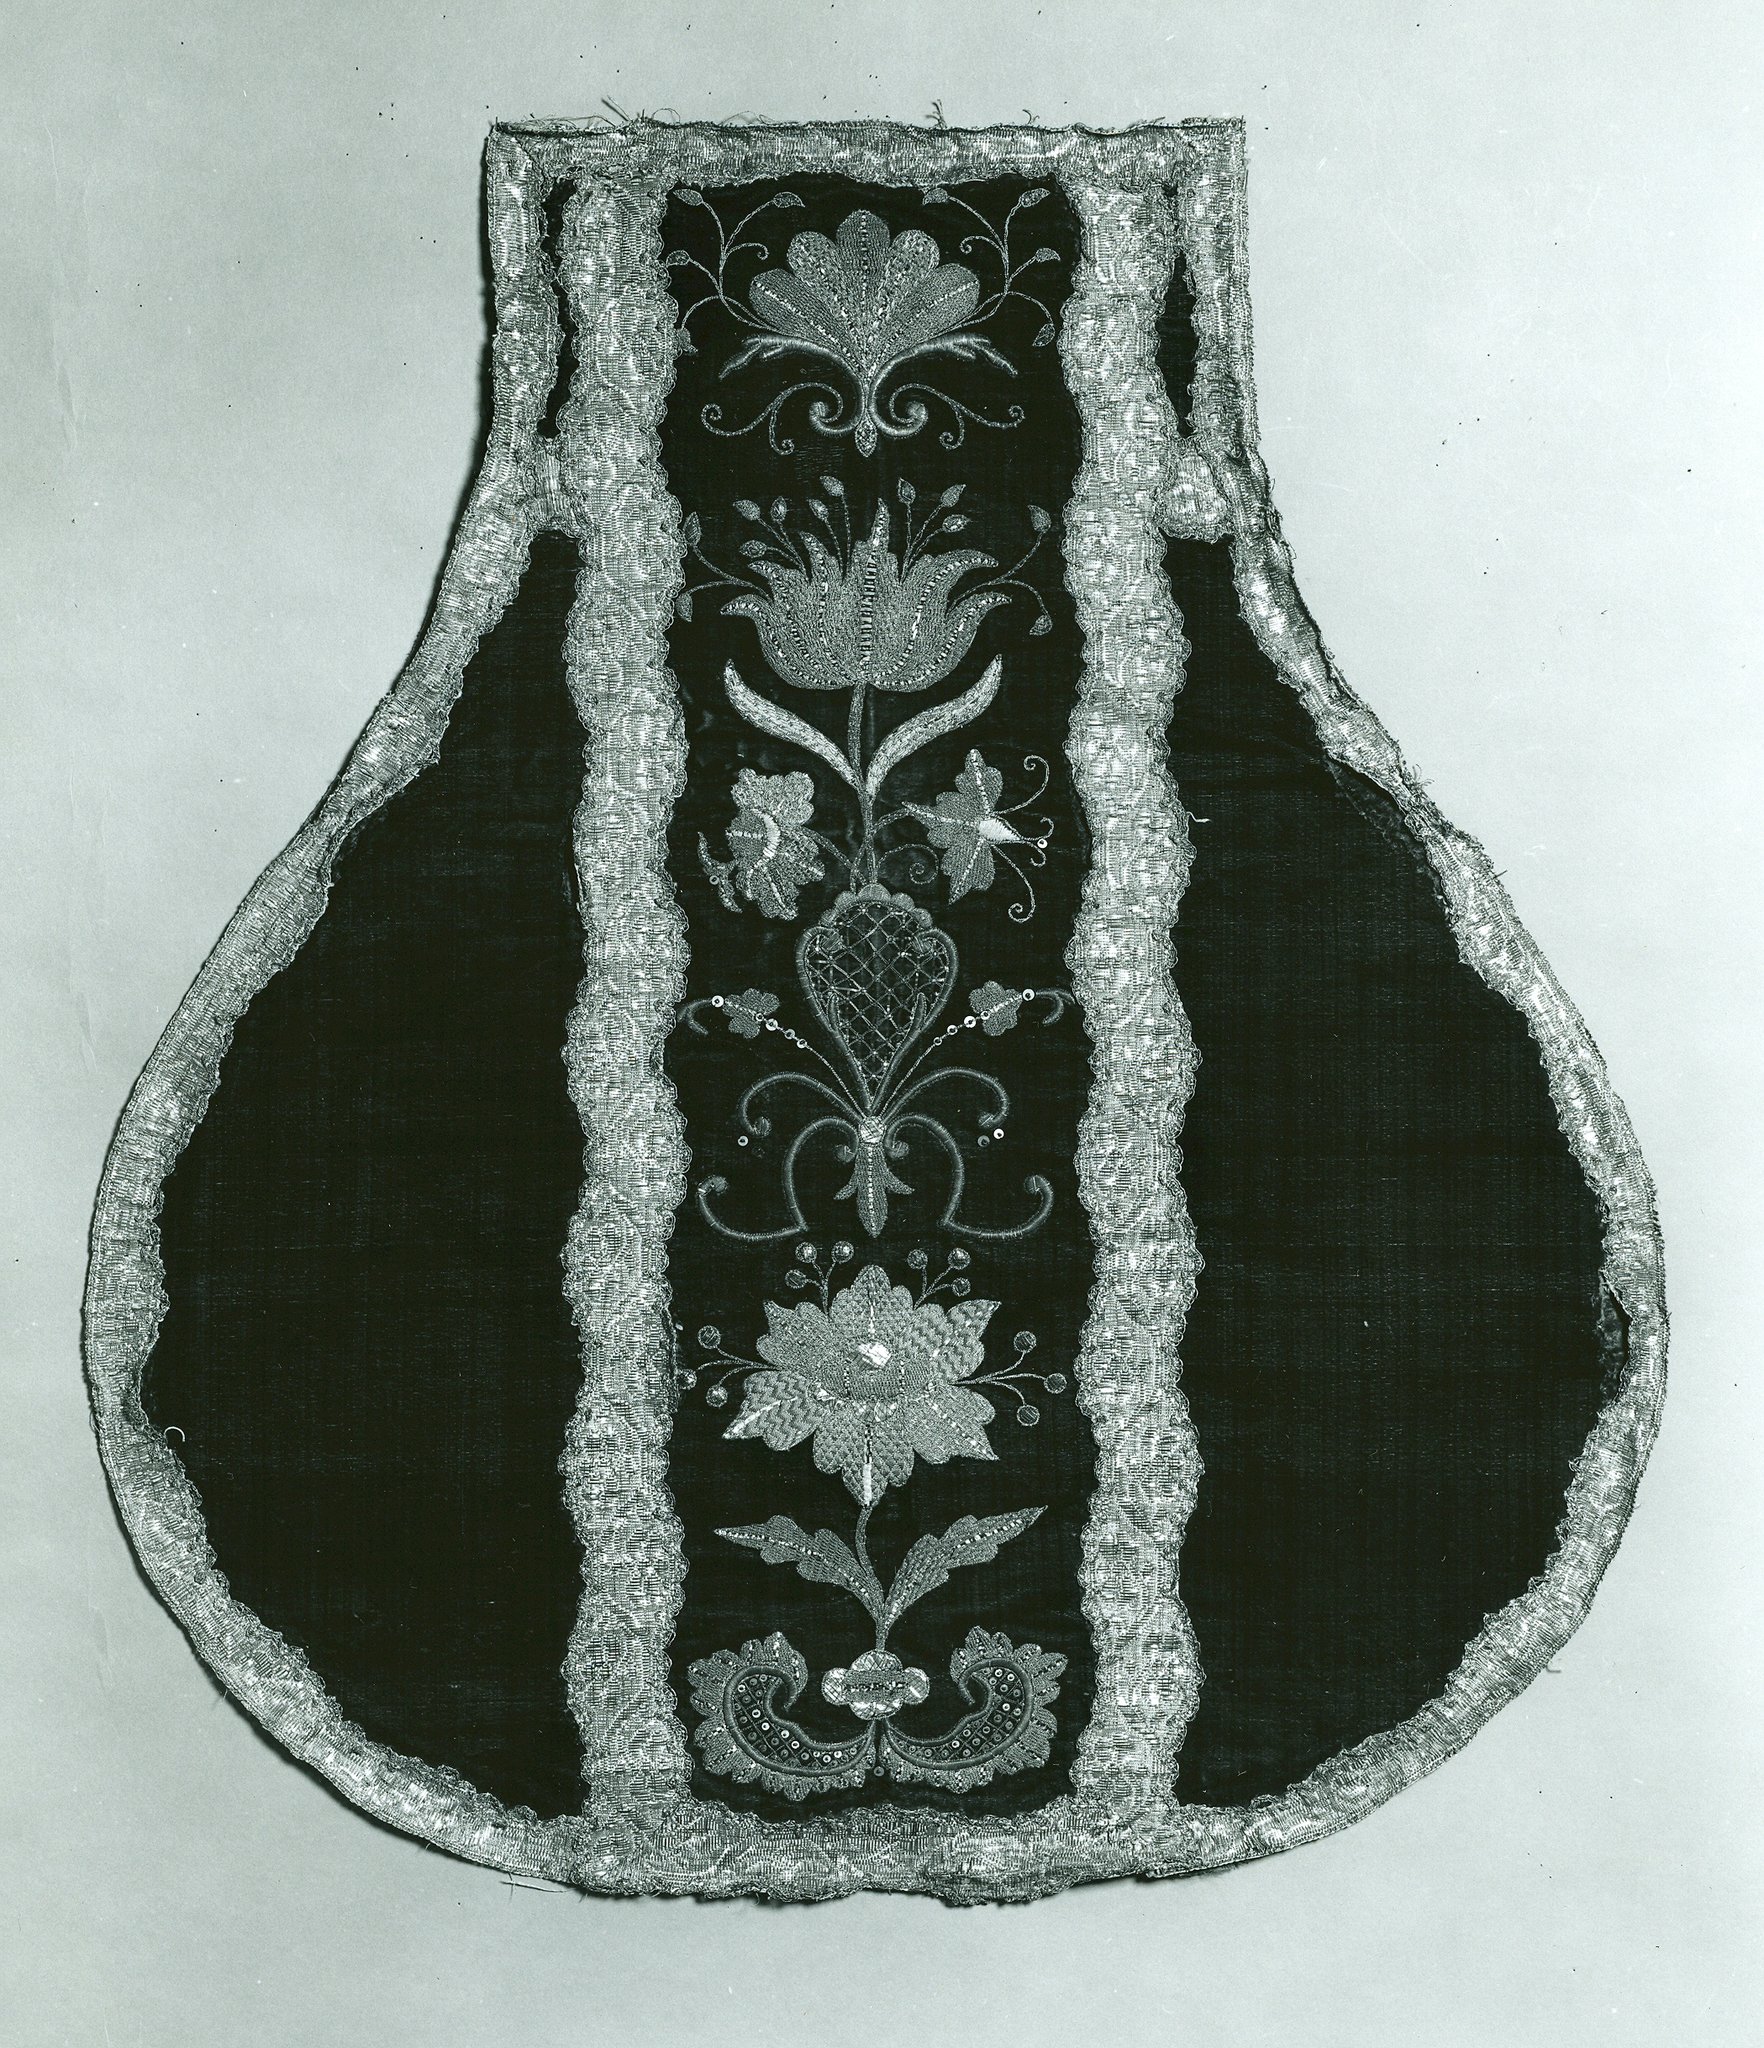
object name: chasuble front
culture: italian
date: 1701-1800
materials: linen, metal, paper, silk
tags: flowers